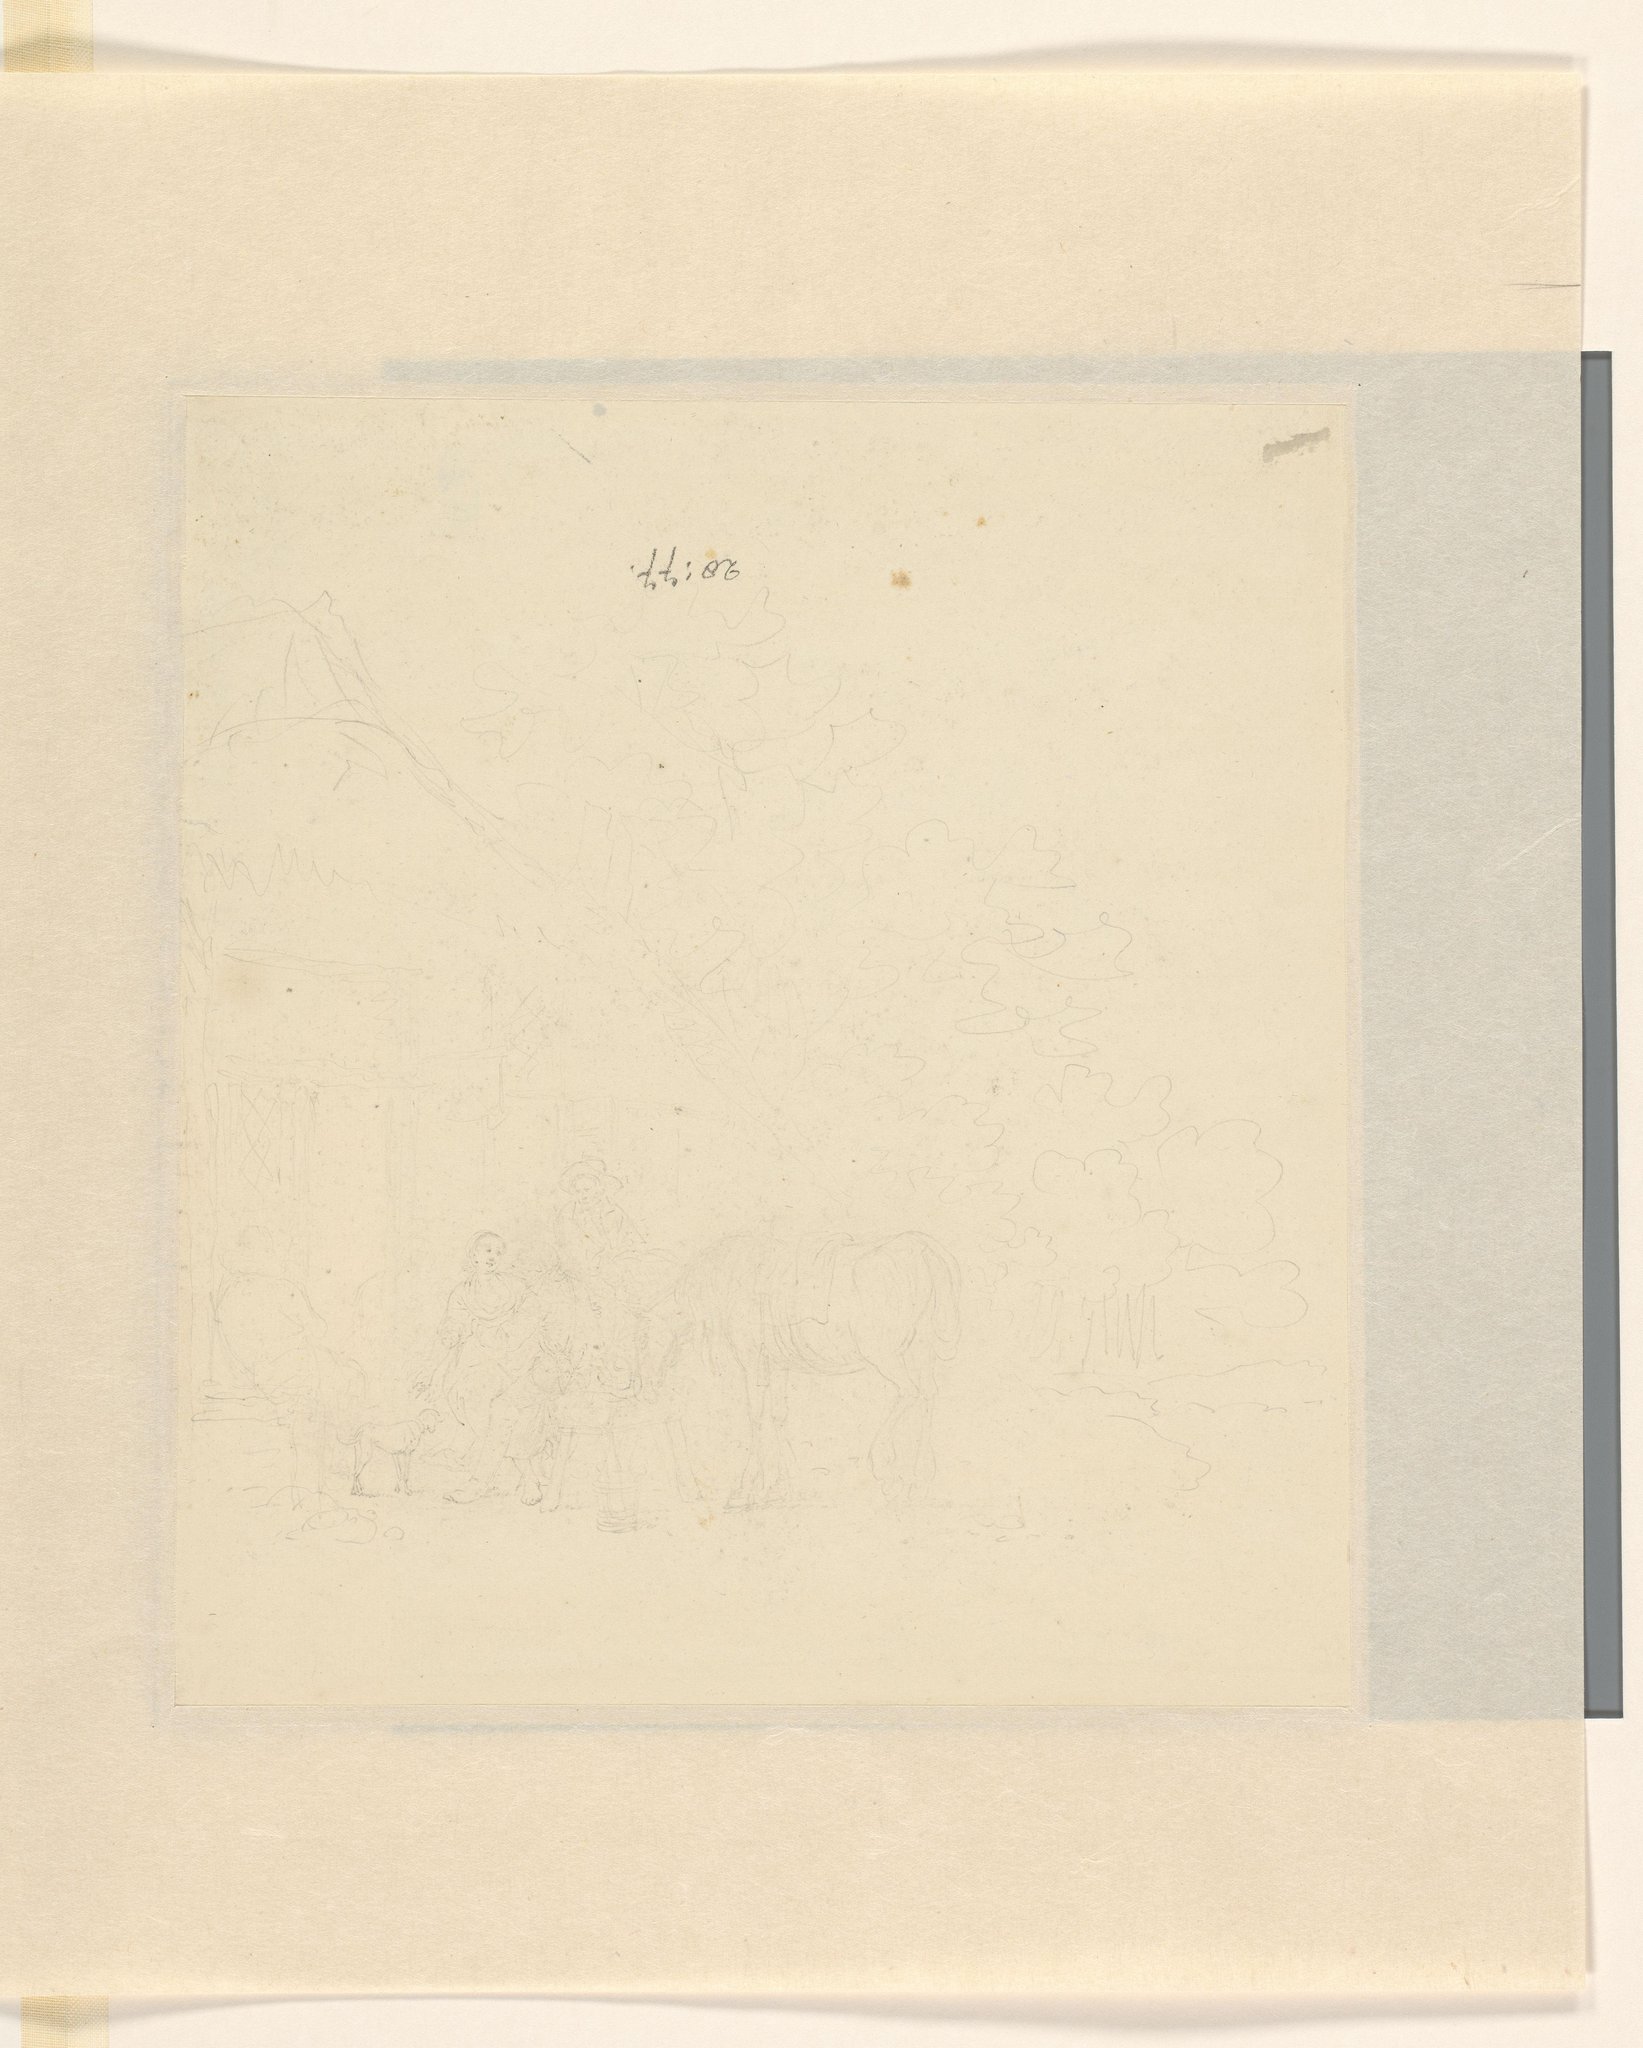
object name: drawing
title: Schets voor een rustende ruiter bij herberg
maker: dirk jan van der laan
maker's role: draughtsman, painter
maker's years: 1759-1829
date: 1783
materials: paper, pencil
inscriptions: date: ‘1783’